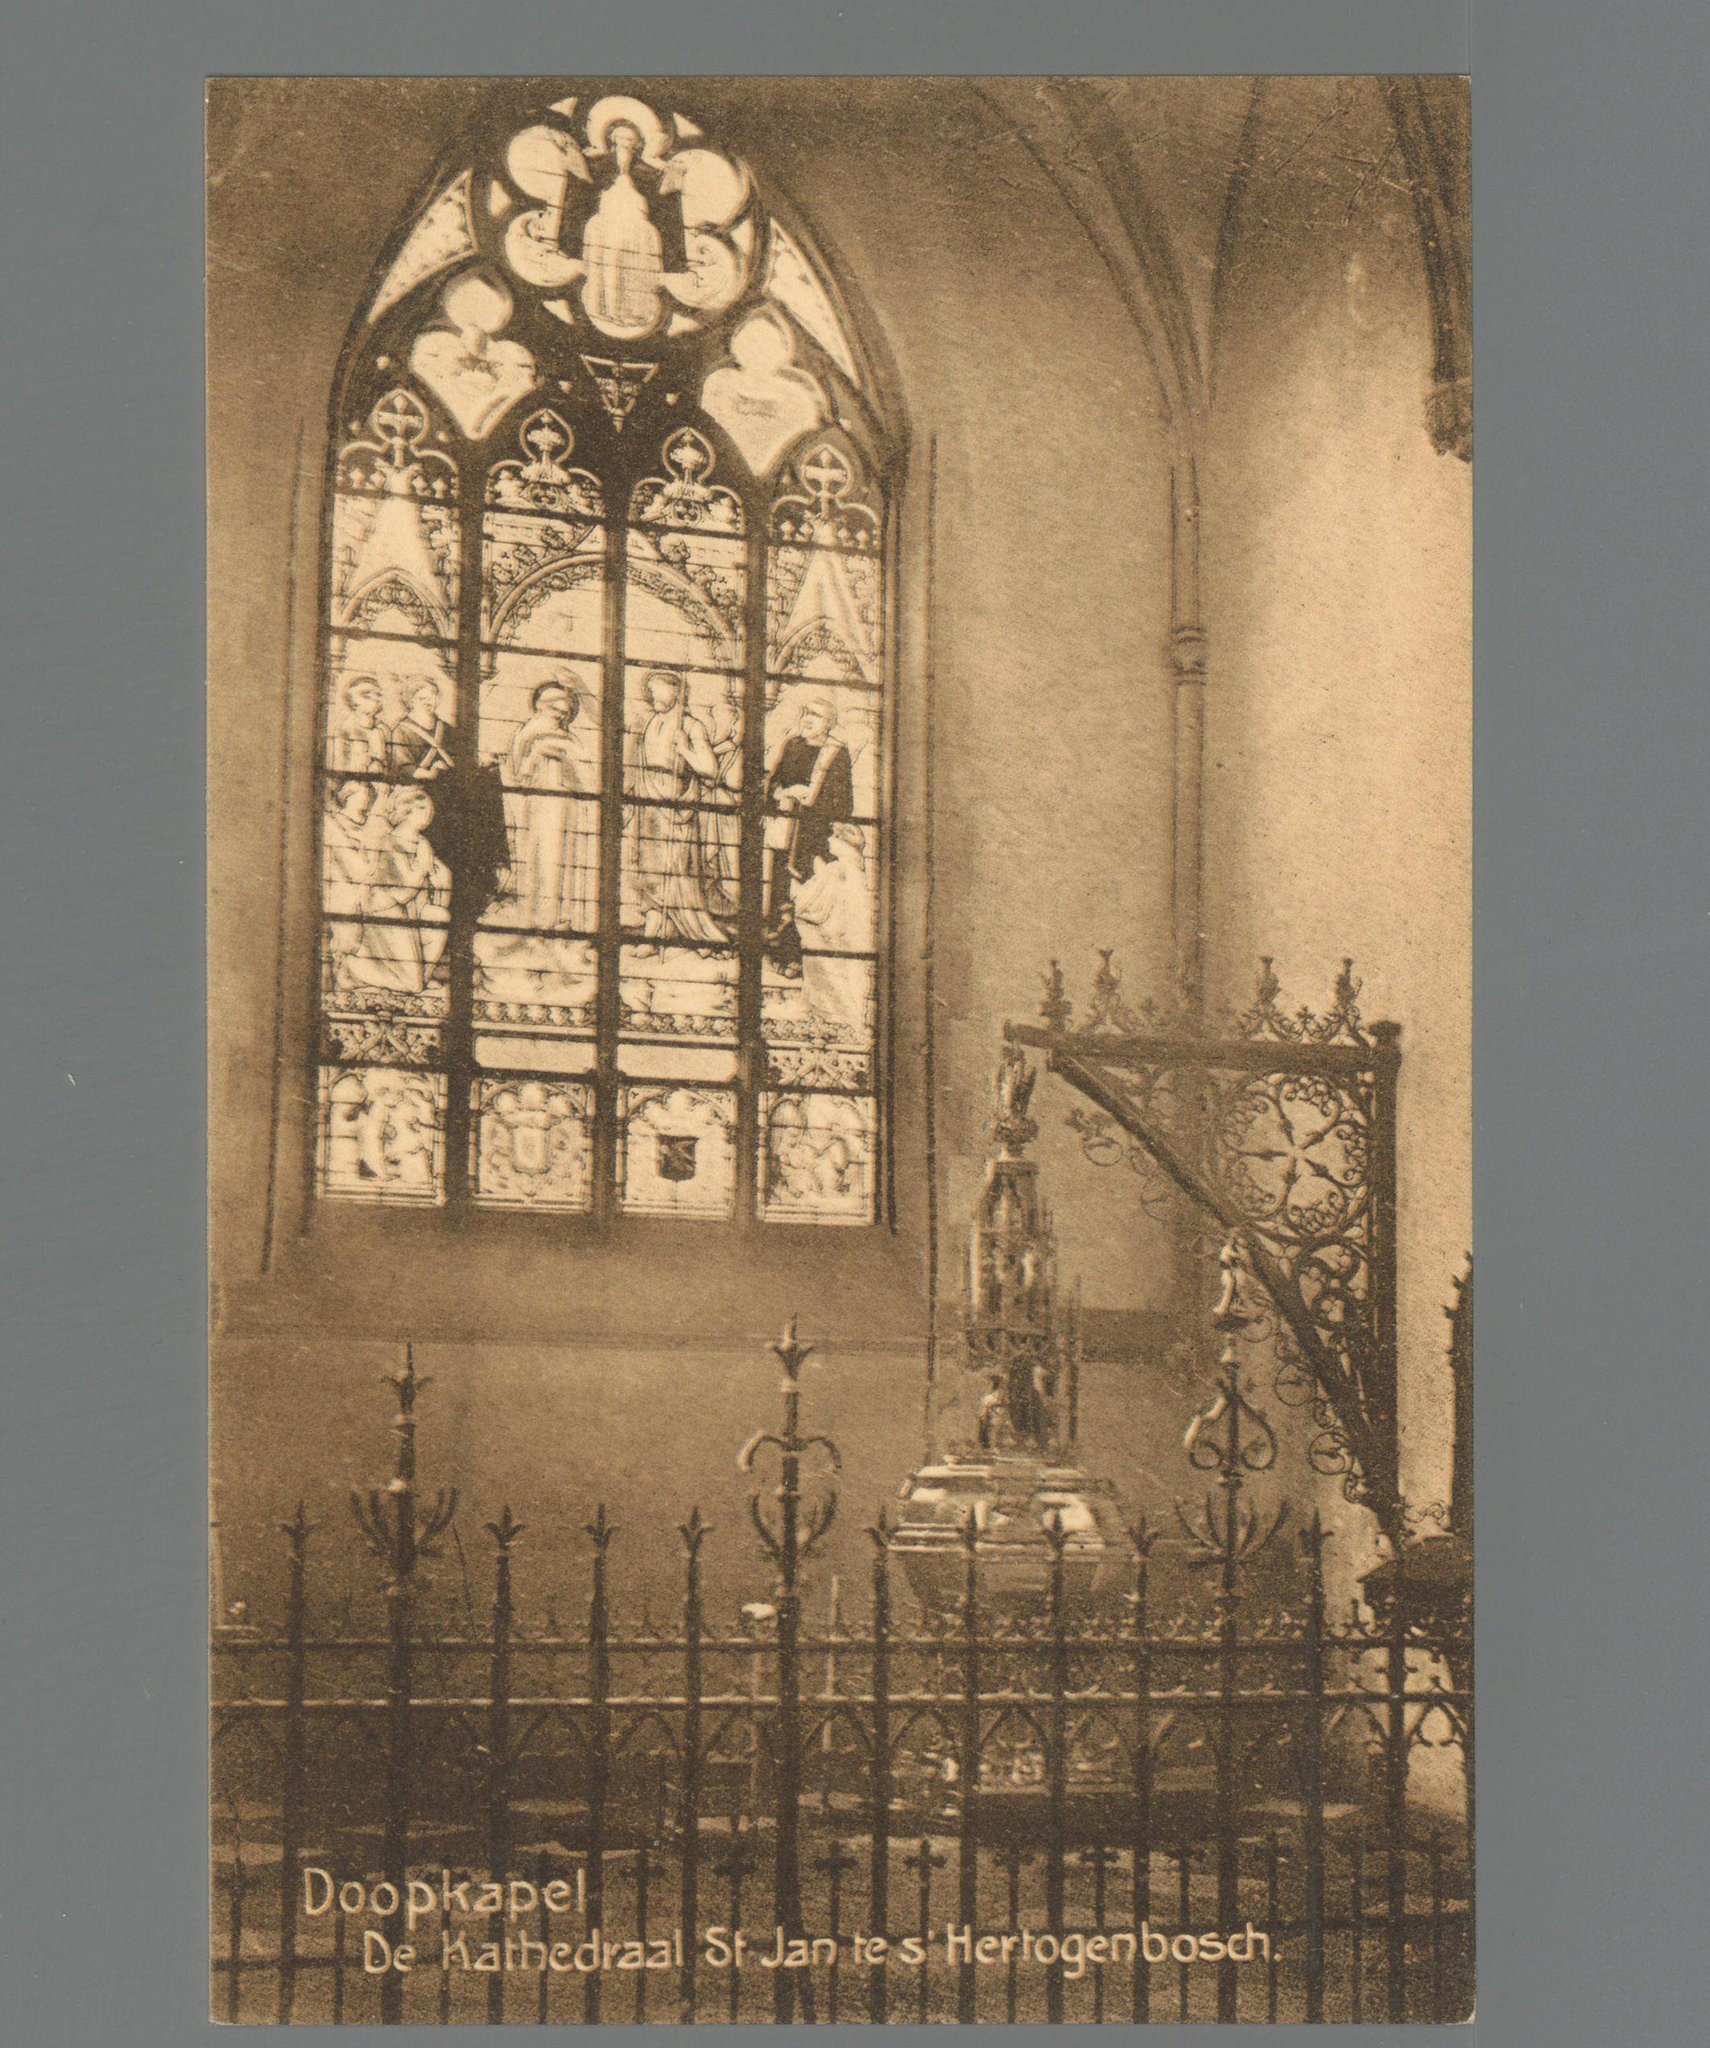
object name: photomechanical print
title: De Kathedraal St Jan te s' Hertogenbosch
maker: Anonymous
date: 1905-1930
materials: cardboard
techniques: photograph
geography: den bosch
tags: baptismal font, parts of church interior: chapel